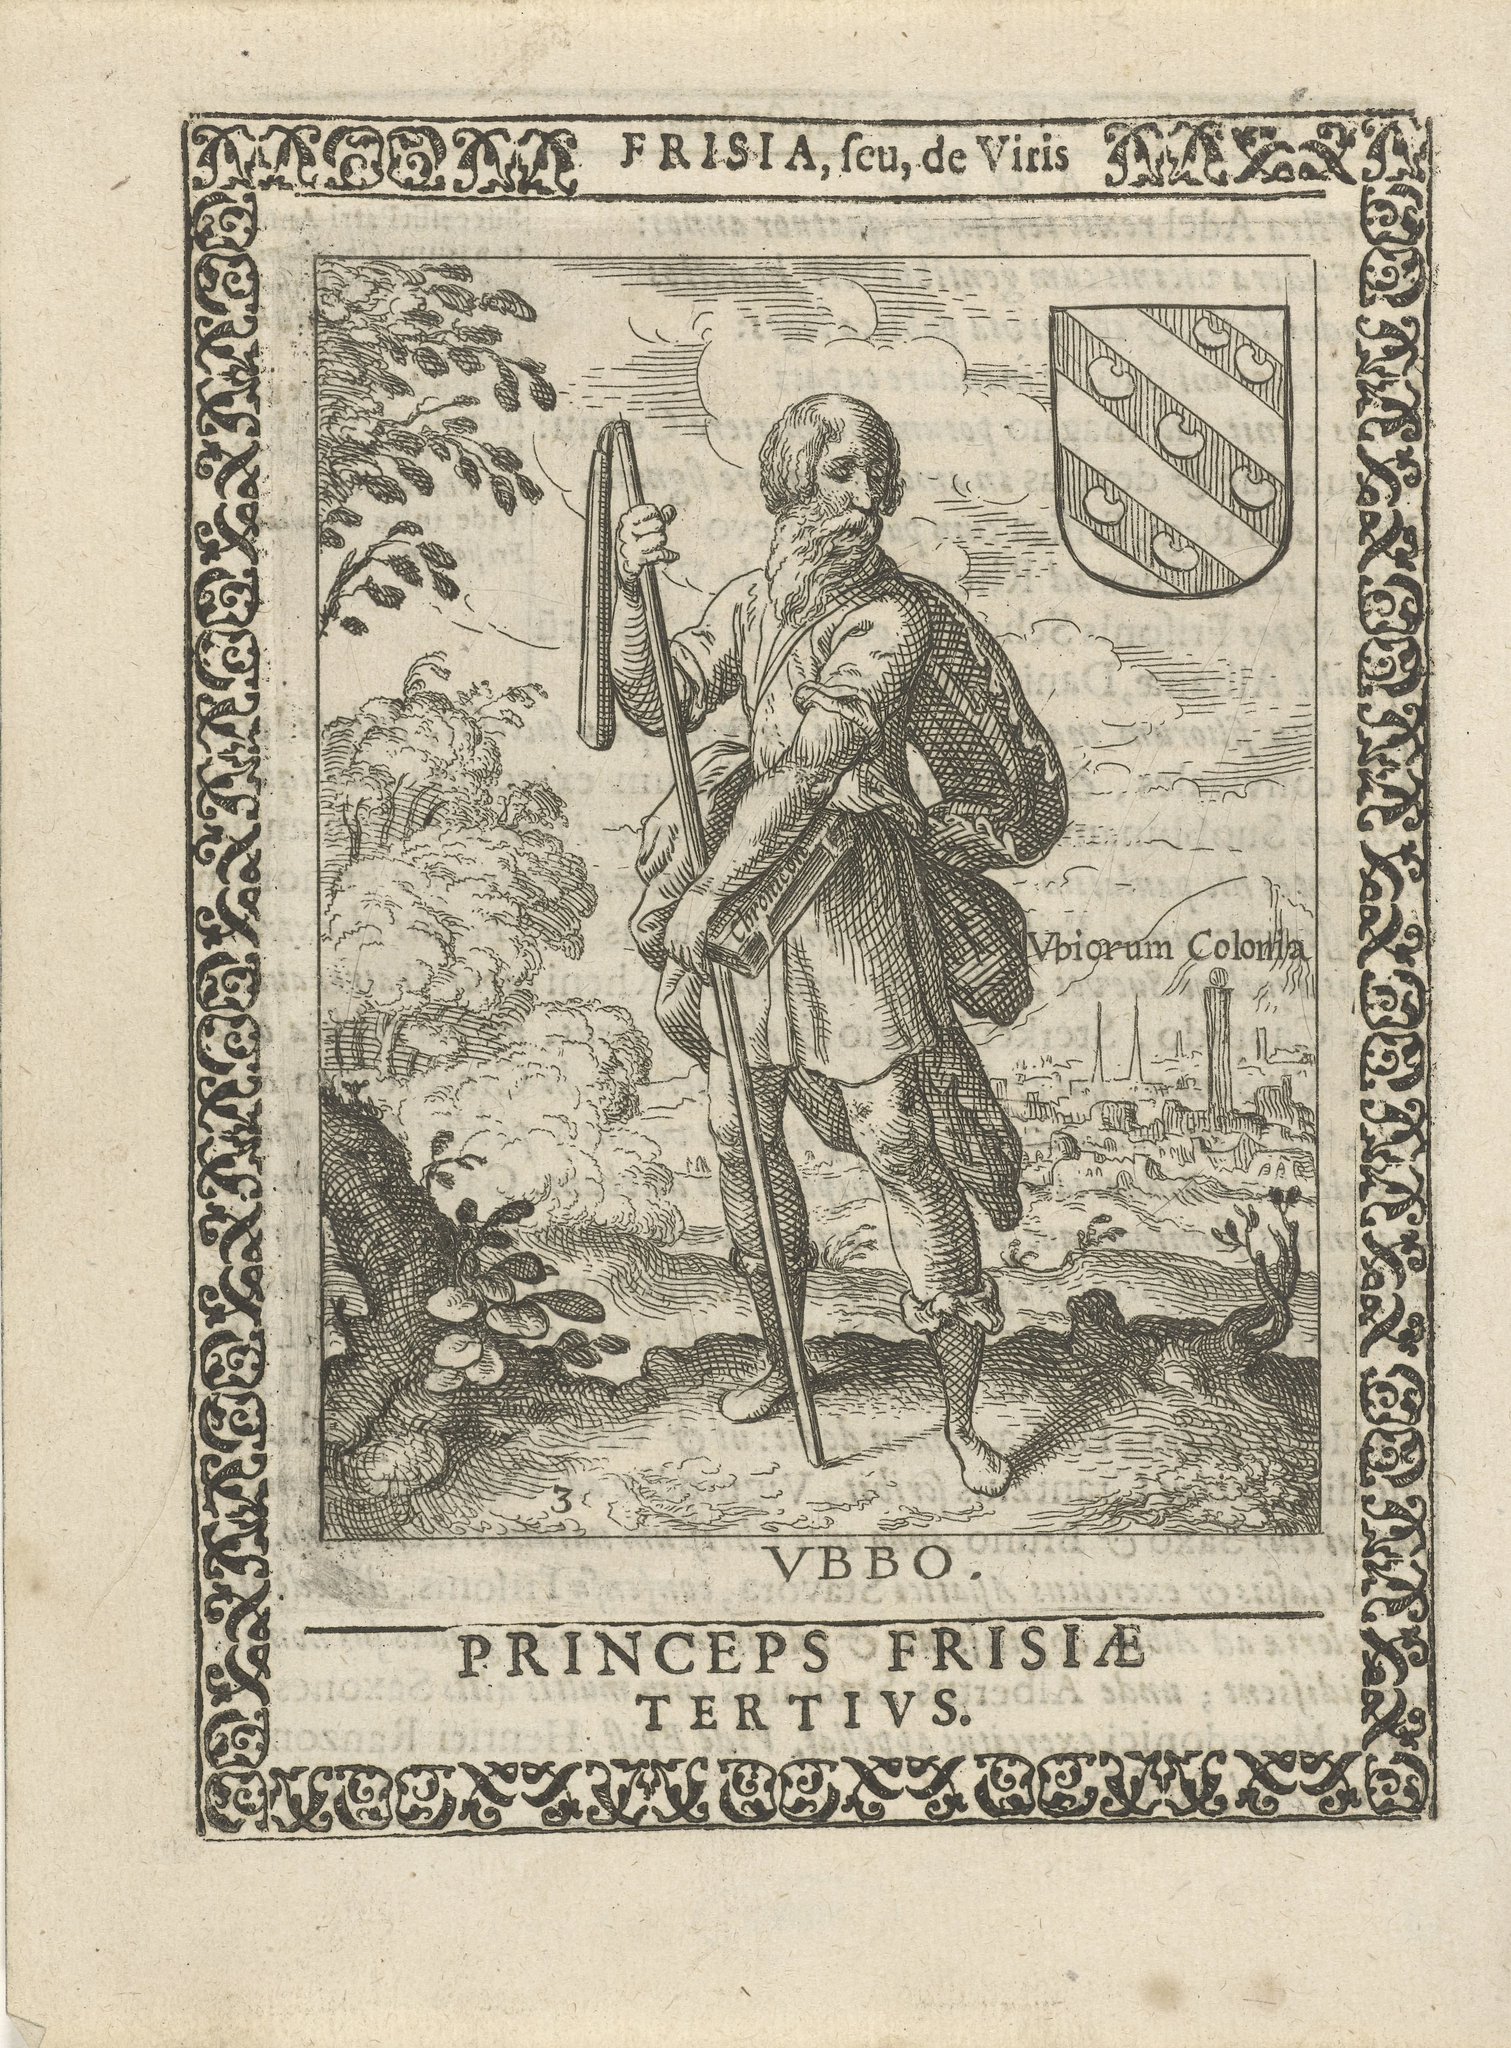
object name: print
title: Frisia, sev, de Viris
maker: pieter feddes van harlingen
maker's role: painter, print maker, publisher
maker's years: 1586-1623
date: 1618-1620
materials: paper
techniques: etching, letterpress printing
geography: friesland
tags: ruler, sovereign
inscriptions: collector's mark: Lugt 2228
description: Ubbo, derde prins der Friezen. Staande ten voeten uit, dorsvlegel in de hand. Op de achtergrond Keulen. In een ornamentale omlijsting. Illustratie, met tekst op achterzijde, afkomstig uit het boek: Frisia seu de viris rebusque Frisiae illustribus libri duo.